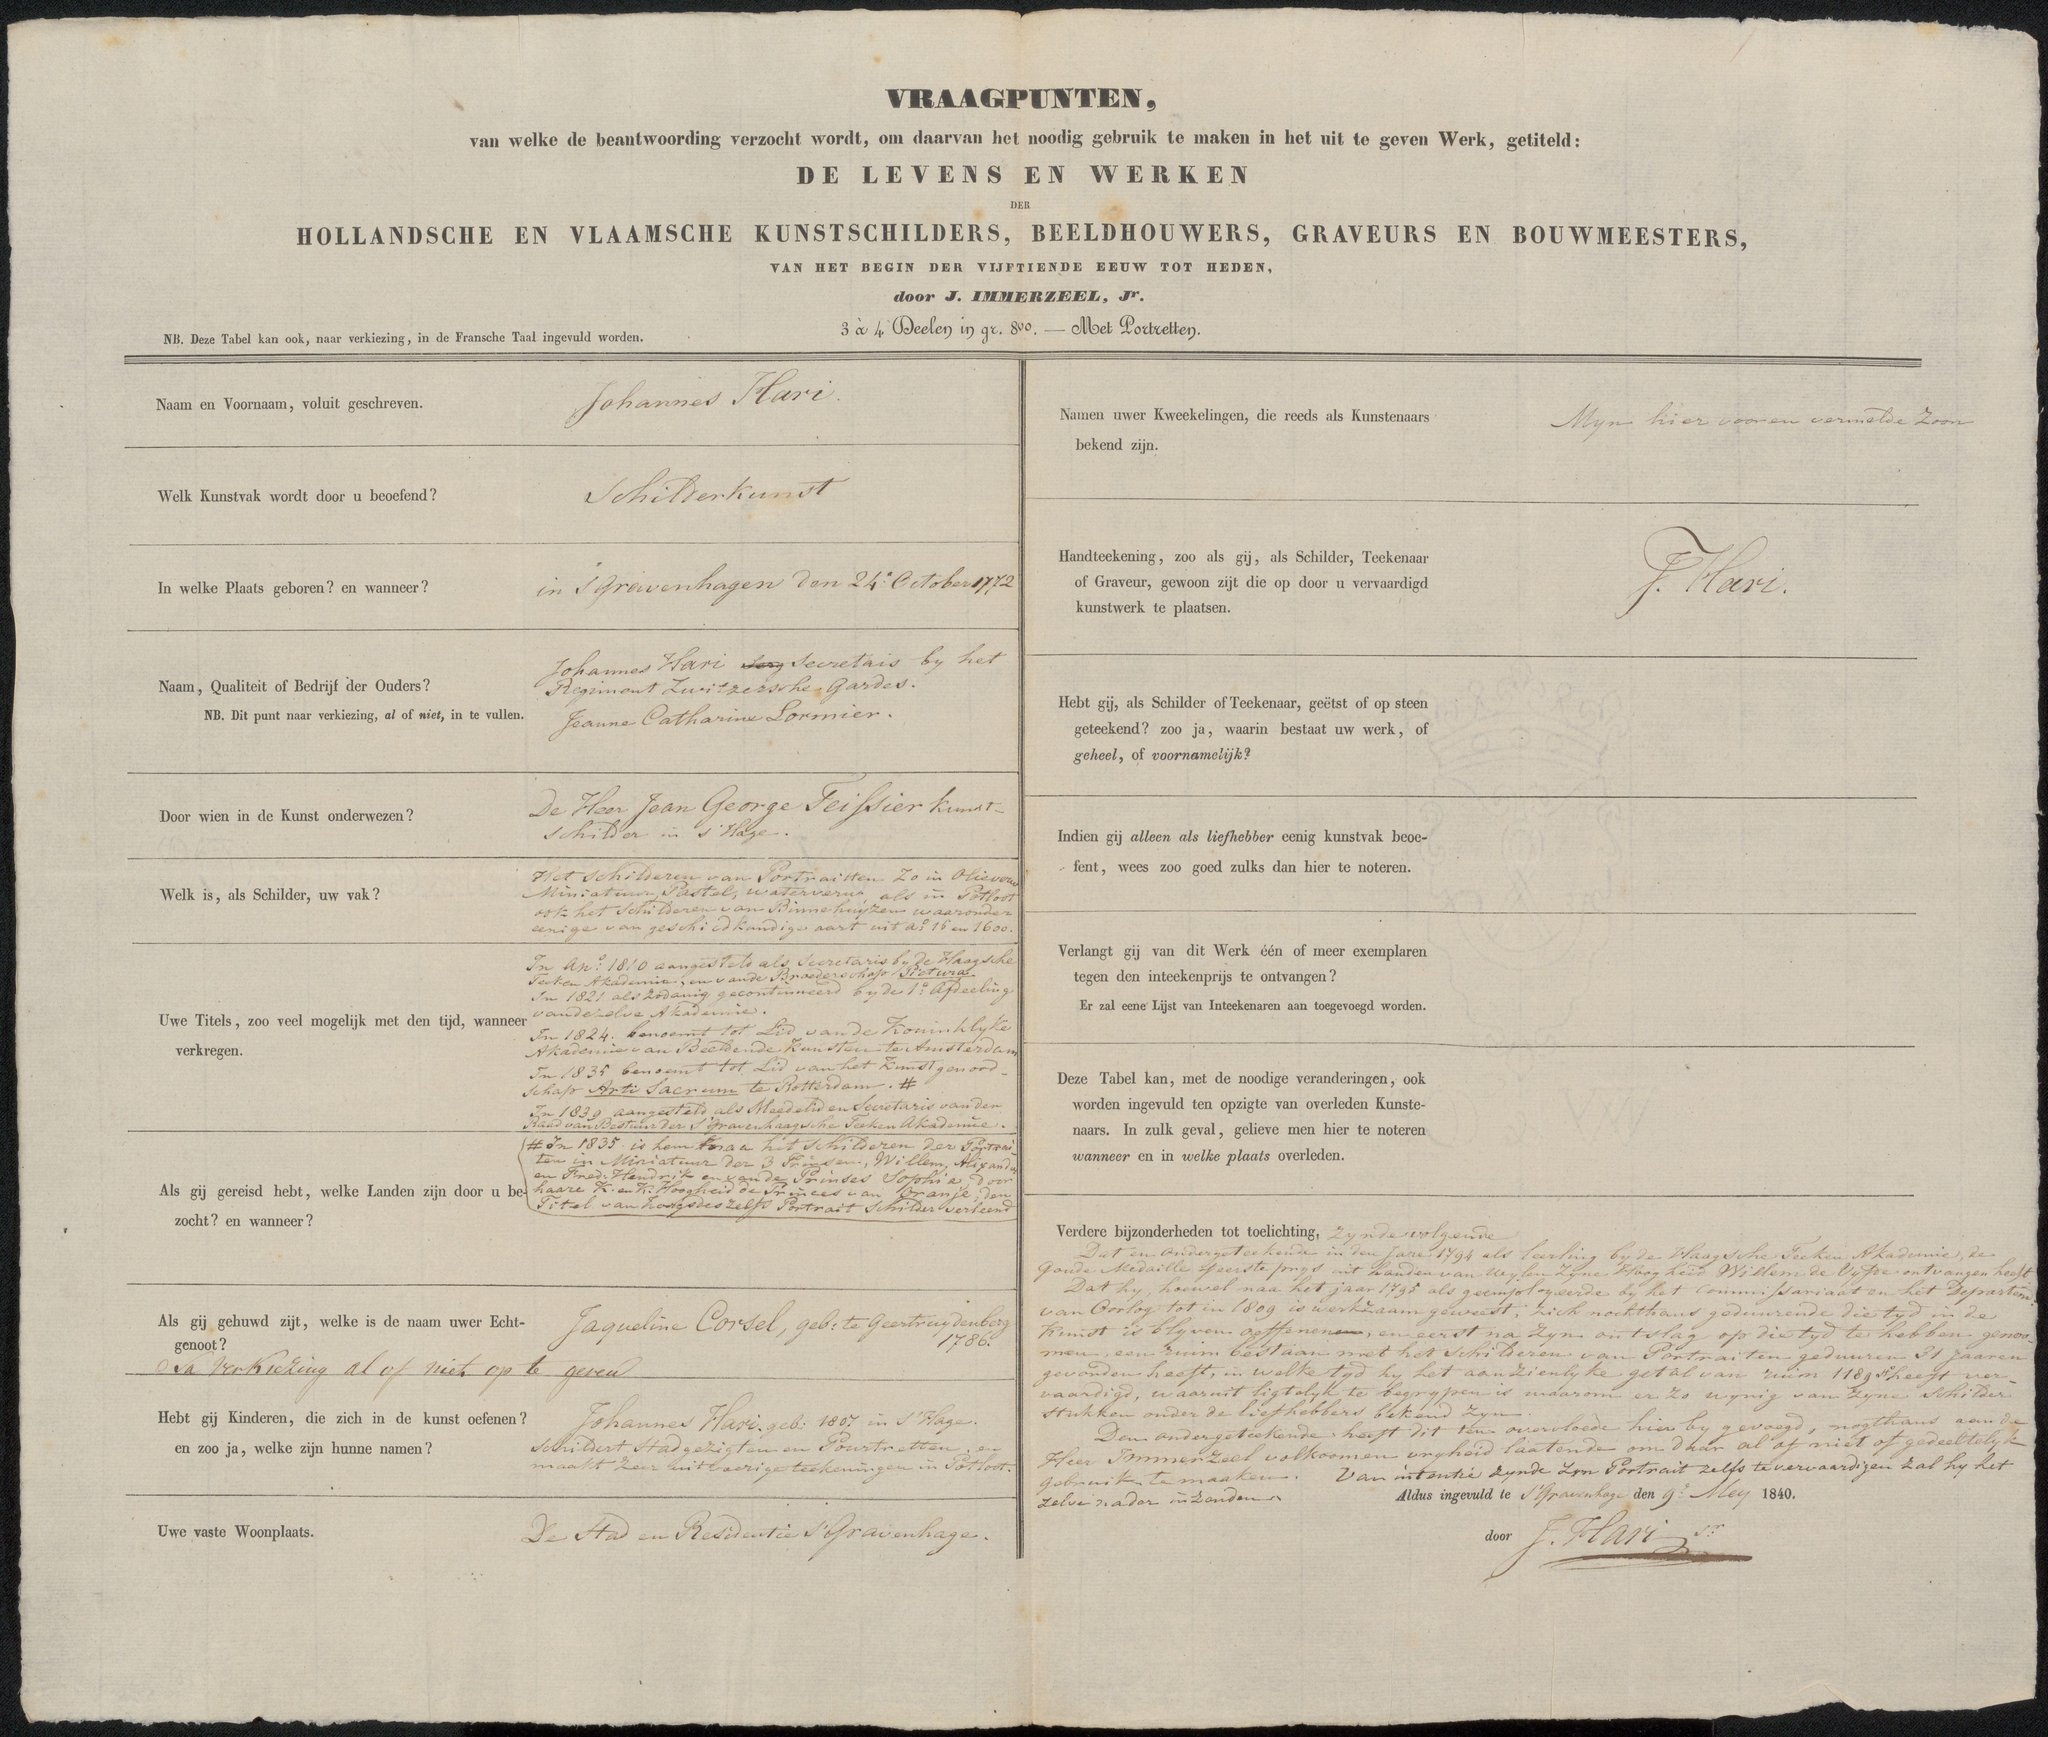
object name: manuscript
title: Enquêteformulier ingevuld door Johannes Hari (I)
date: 1840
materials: ink, paper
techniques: pen, printing, writing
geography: the hague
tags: the hague, painter, print maker, draughtsman, johannes hari (i)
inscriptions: watermark, inscription: ‘Vraagpunten,/ van welke de beantwoording verzocht wordt, om daarvan het noodig gebruik te maken in het uit te geven Werk, getiteld: De levens en werken/ der Hollandsche en Vlaamsche kunstschilders, beeldhouwers,/ graveurs en bouwmeesters, van het begin der vijftiende eeuw tot heden/ door J. Immerzeel, Jr.’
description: Opgenomen in: Immerzeel, J. Jr., De levens en werken der Hollandsche en Vlaamsche kunstschilders, beeldhouwers, graveurs en bouwmeesters, van het begin der vijftiende eeuw tot heden, Amsterdam: J.C. van Kesteren, 1842-1843.